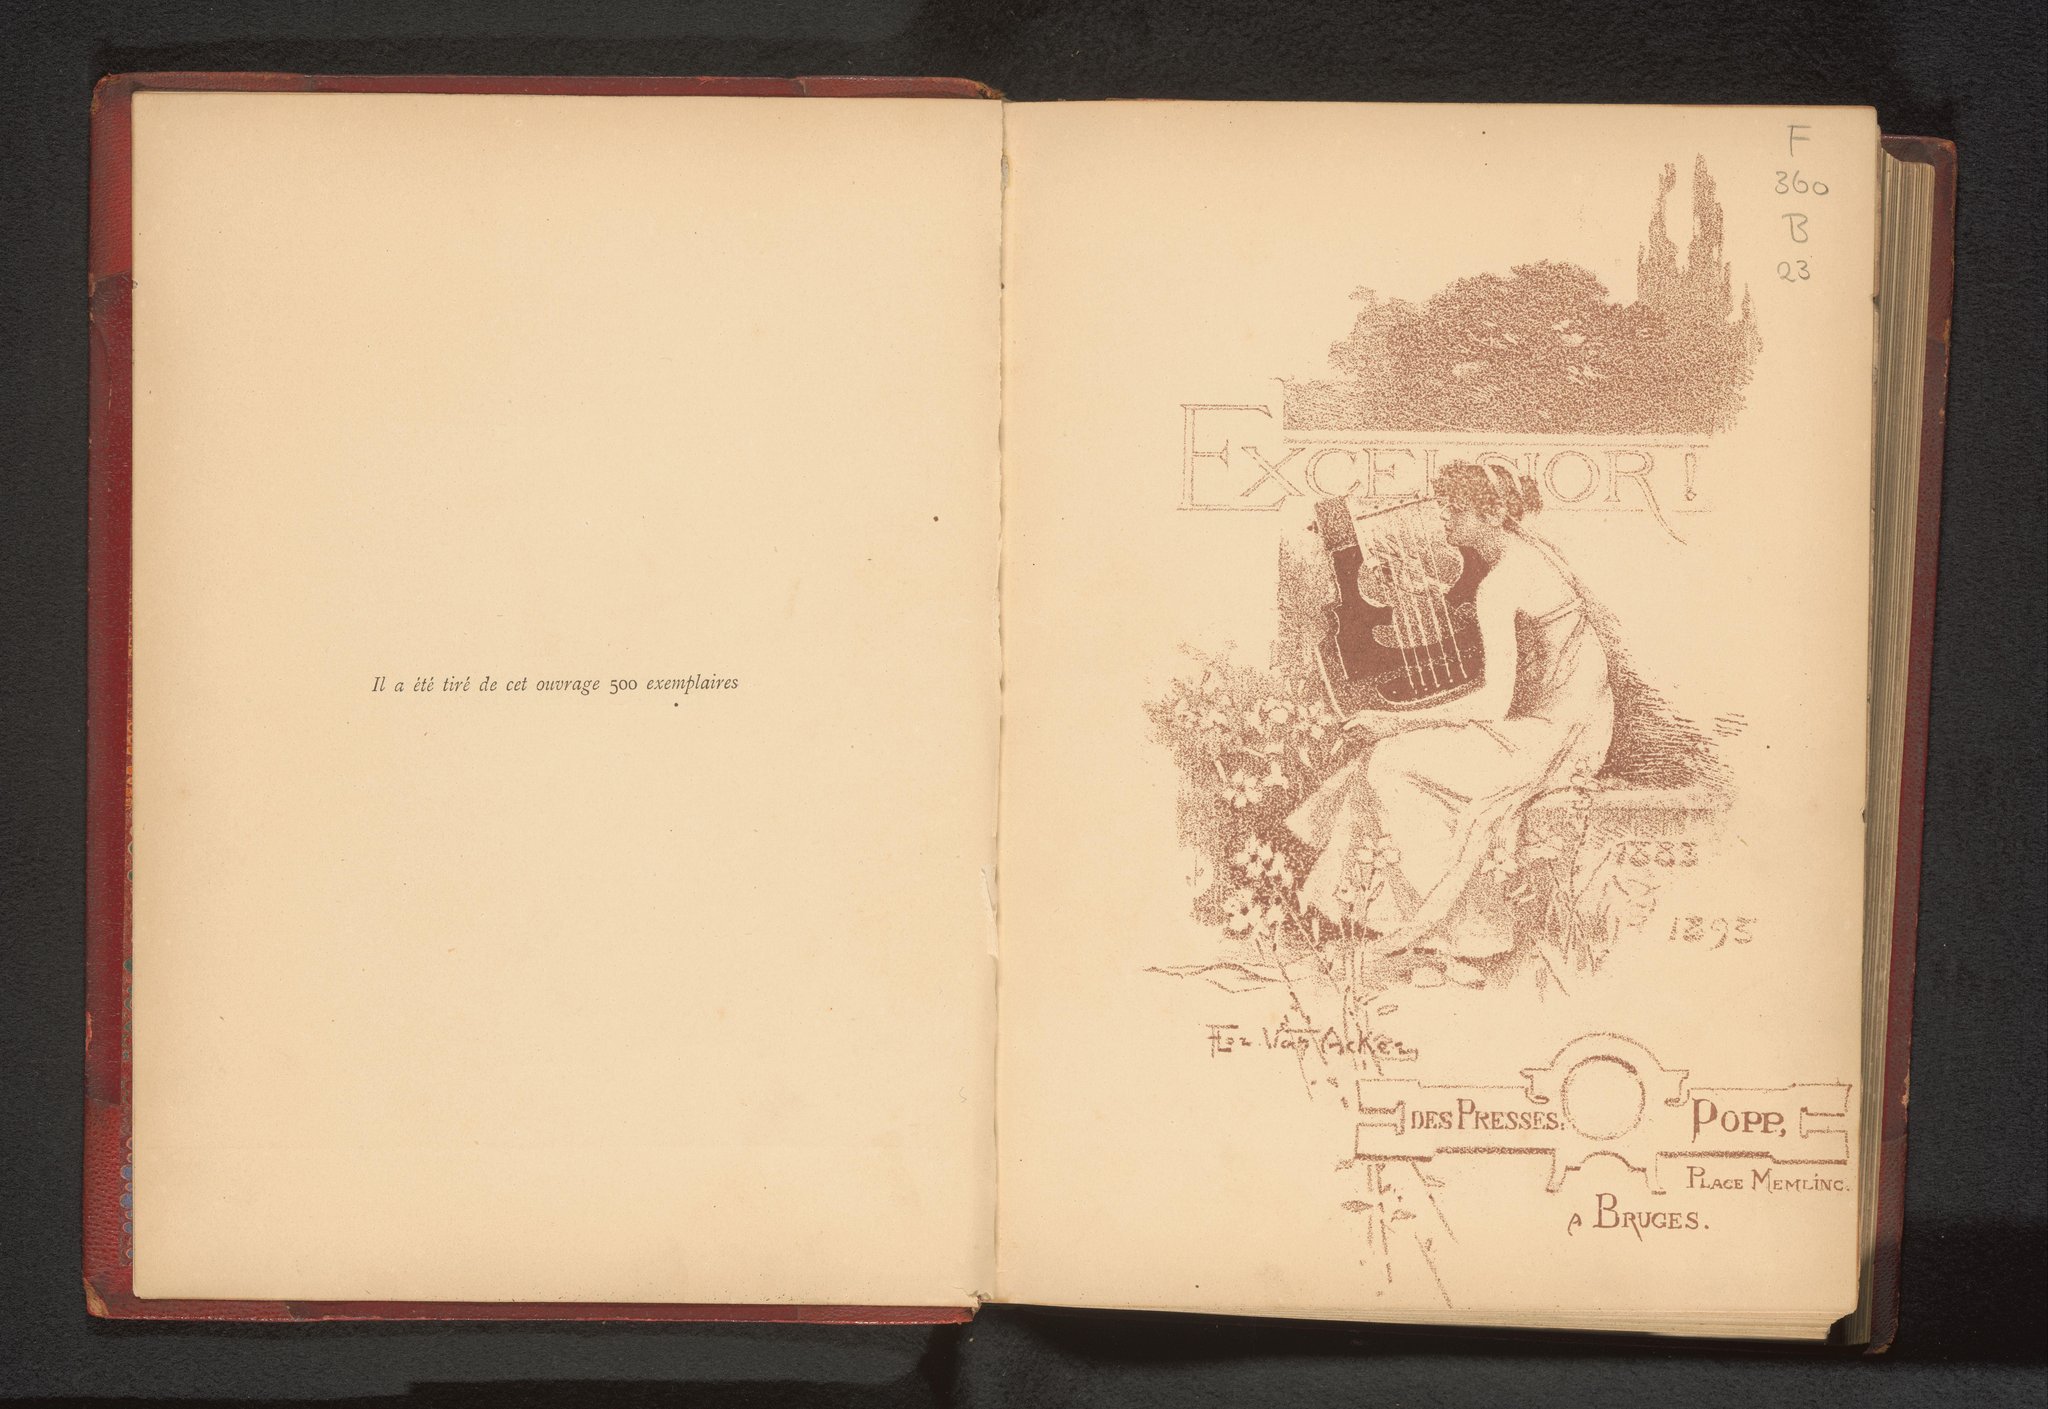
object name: book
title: Excelsior! : 1883-1893 / [comité de publication: Alfred Algrain (...) et al.]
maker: philippe chrétien popp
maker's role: printer, publisher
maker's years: 1805-1879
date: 1893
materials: cardboard, leather, linen, paper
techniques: photograph, marbled paper, lithograph, printing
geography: bruges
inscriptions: annotation: ‘MAY 1983’, bookplate: ‘EX/ SFJ/ LIBRIS’